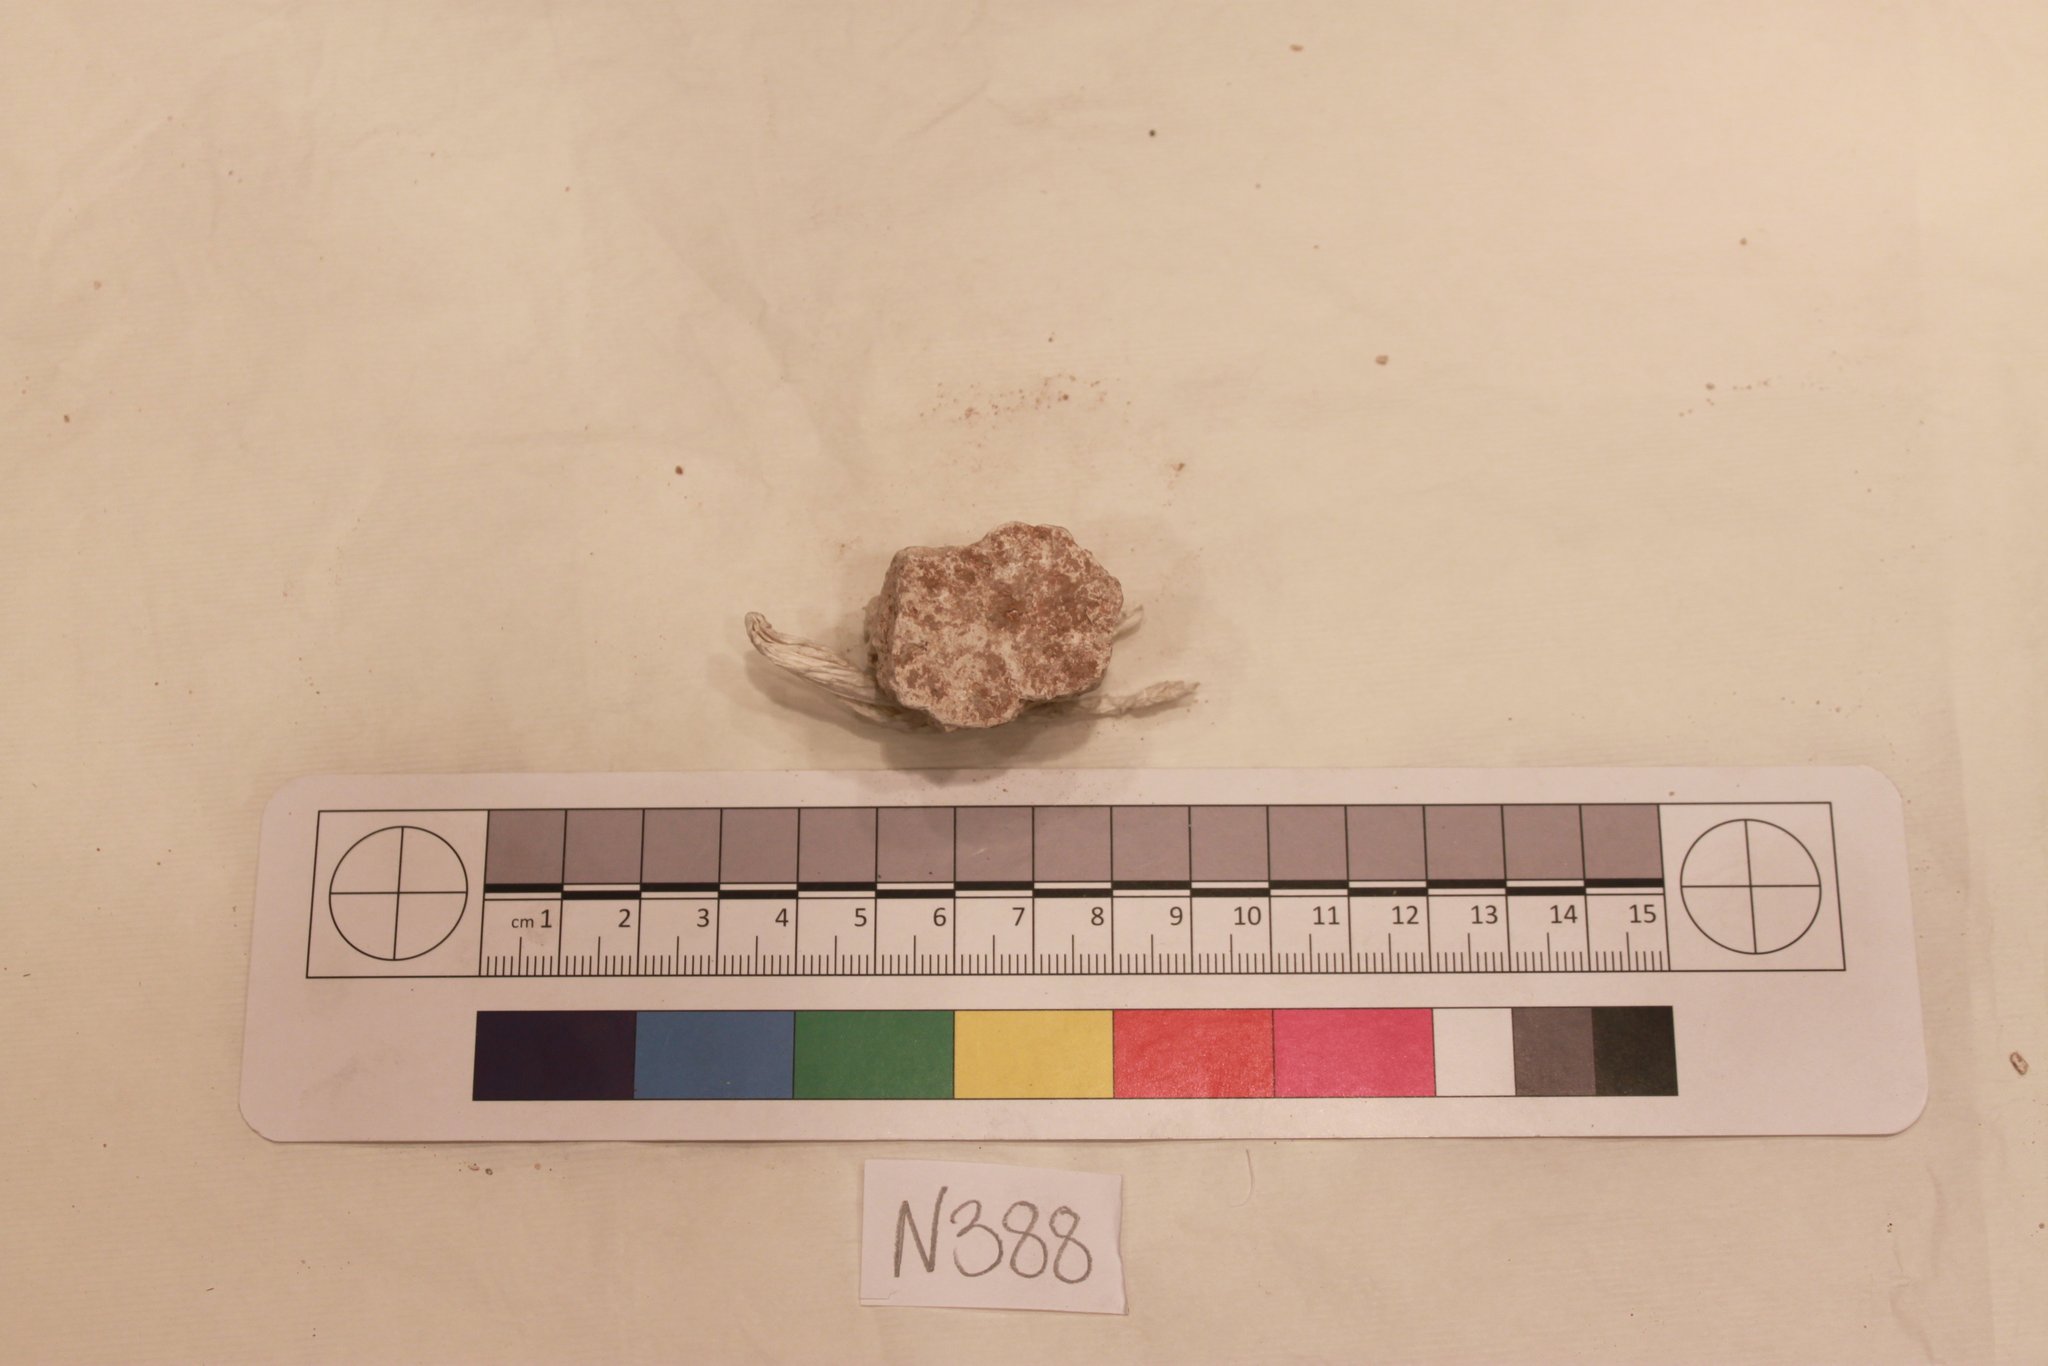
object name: fragment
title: Stucco Fragment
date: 701-1200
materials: plaster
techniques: carving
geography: iran